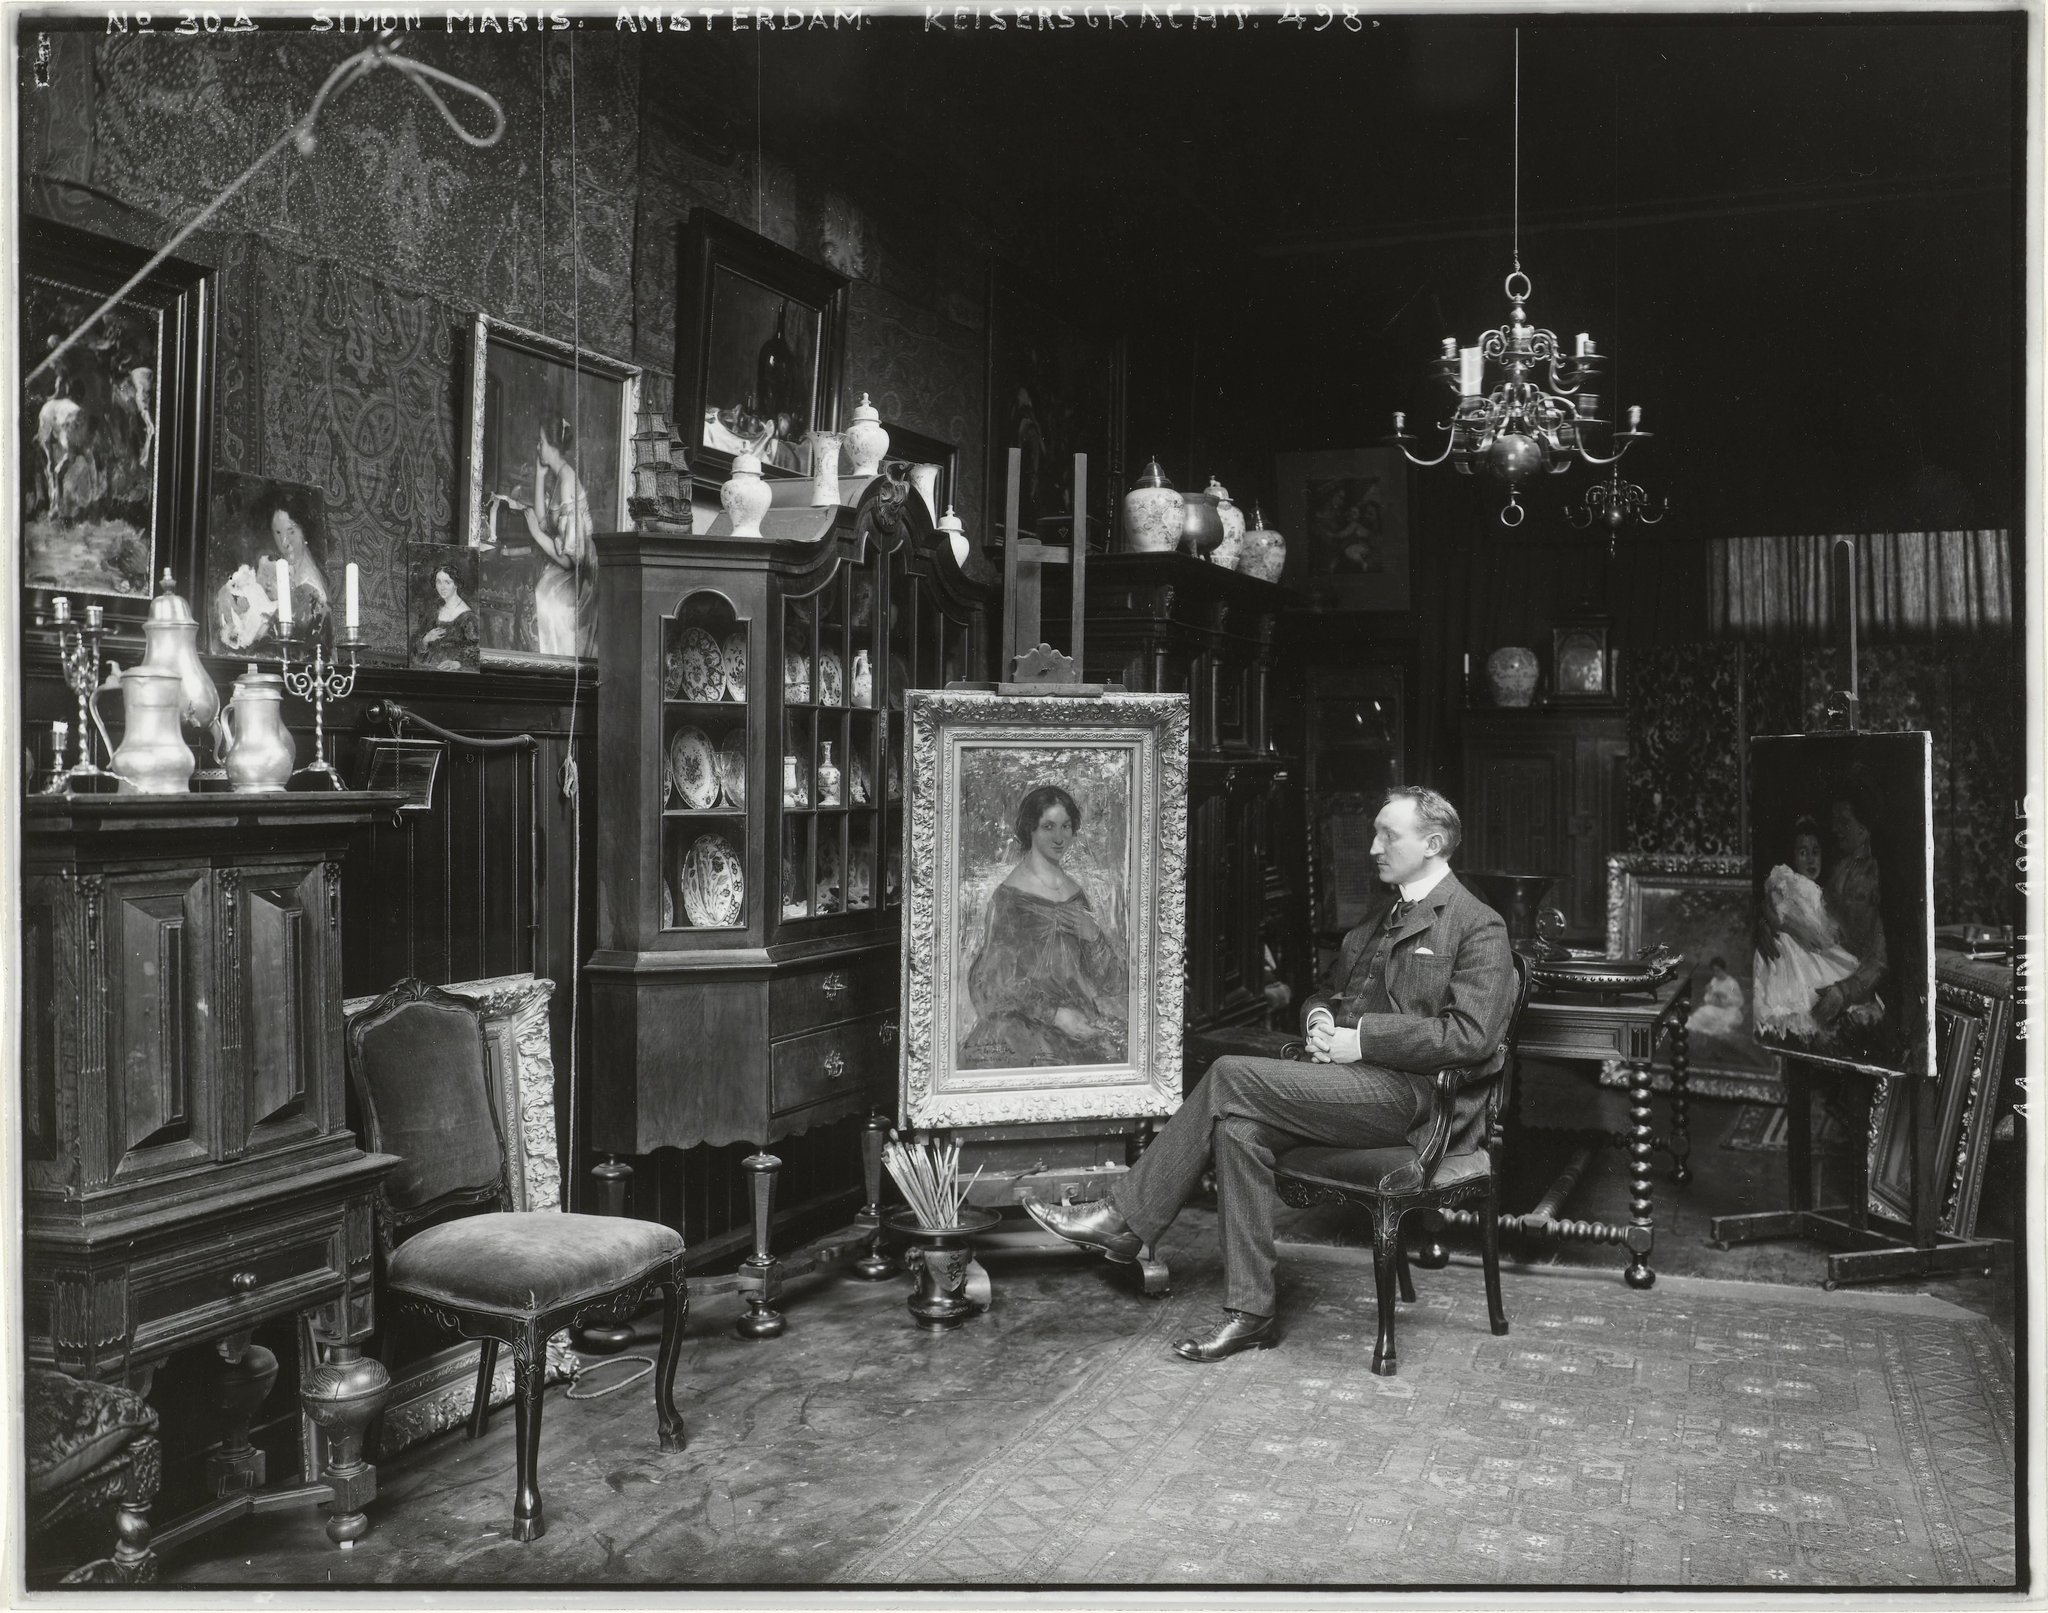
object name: later print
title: Simon Maris in zijn atelier aan de Keizersgracht in Amsterdam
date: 1905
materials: paper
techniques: gelatin silver print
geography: amsterdam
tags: the hague, amsterdam, painter, simon maris, painter at work, in his studio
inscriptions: inscription: ‘No 30A SIMON MARIS, AMSTERDAM, KEIZERSGRACHT A98/ 11 JUNI 1905’, copyright notice: ‘World Copyright by W.M.A. Deppe, Bachlaan, 1 Naarden (Holland) telef. K 2959-5505’